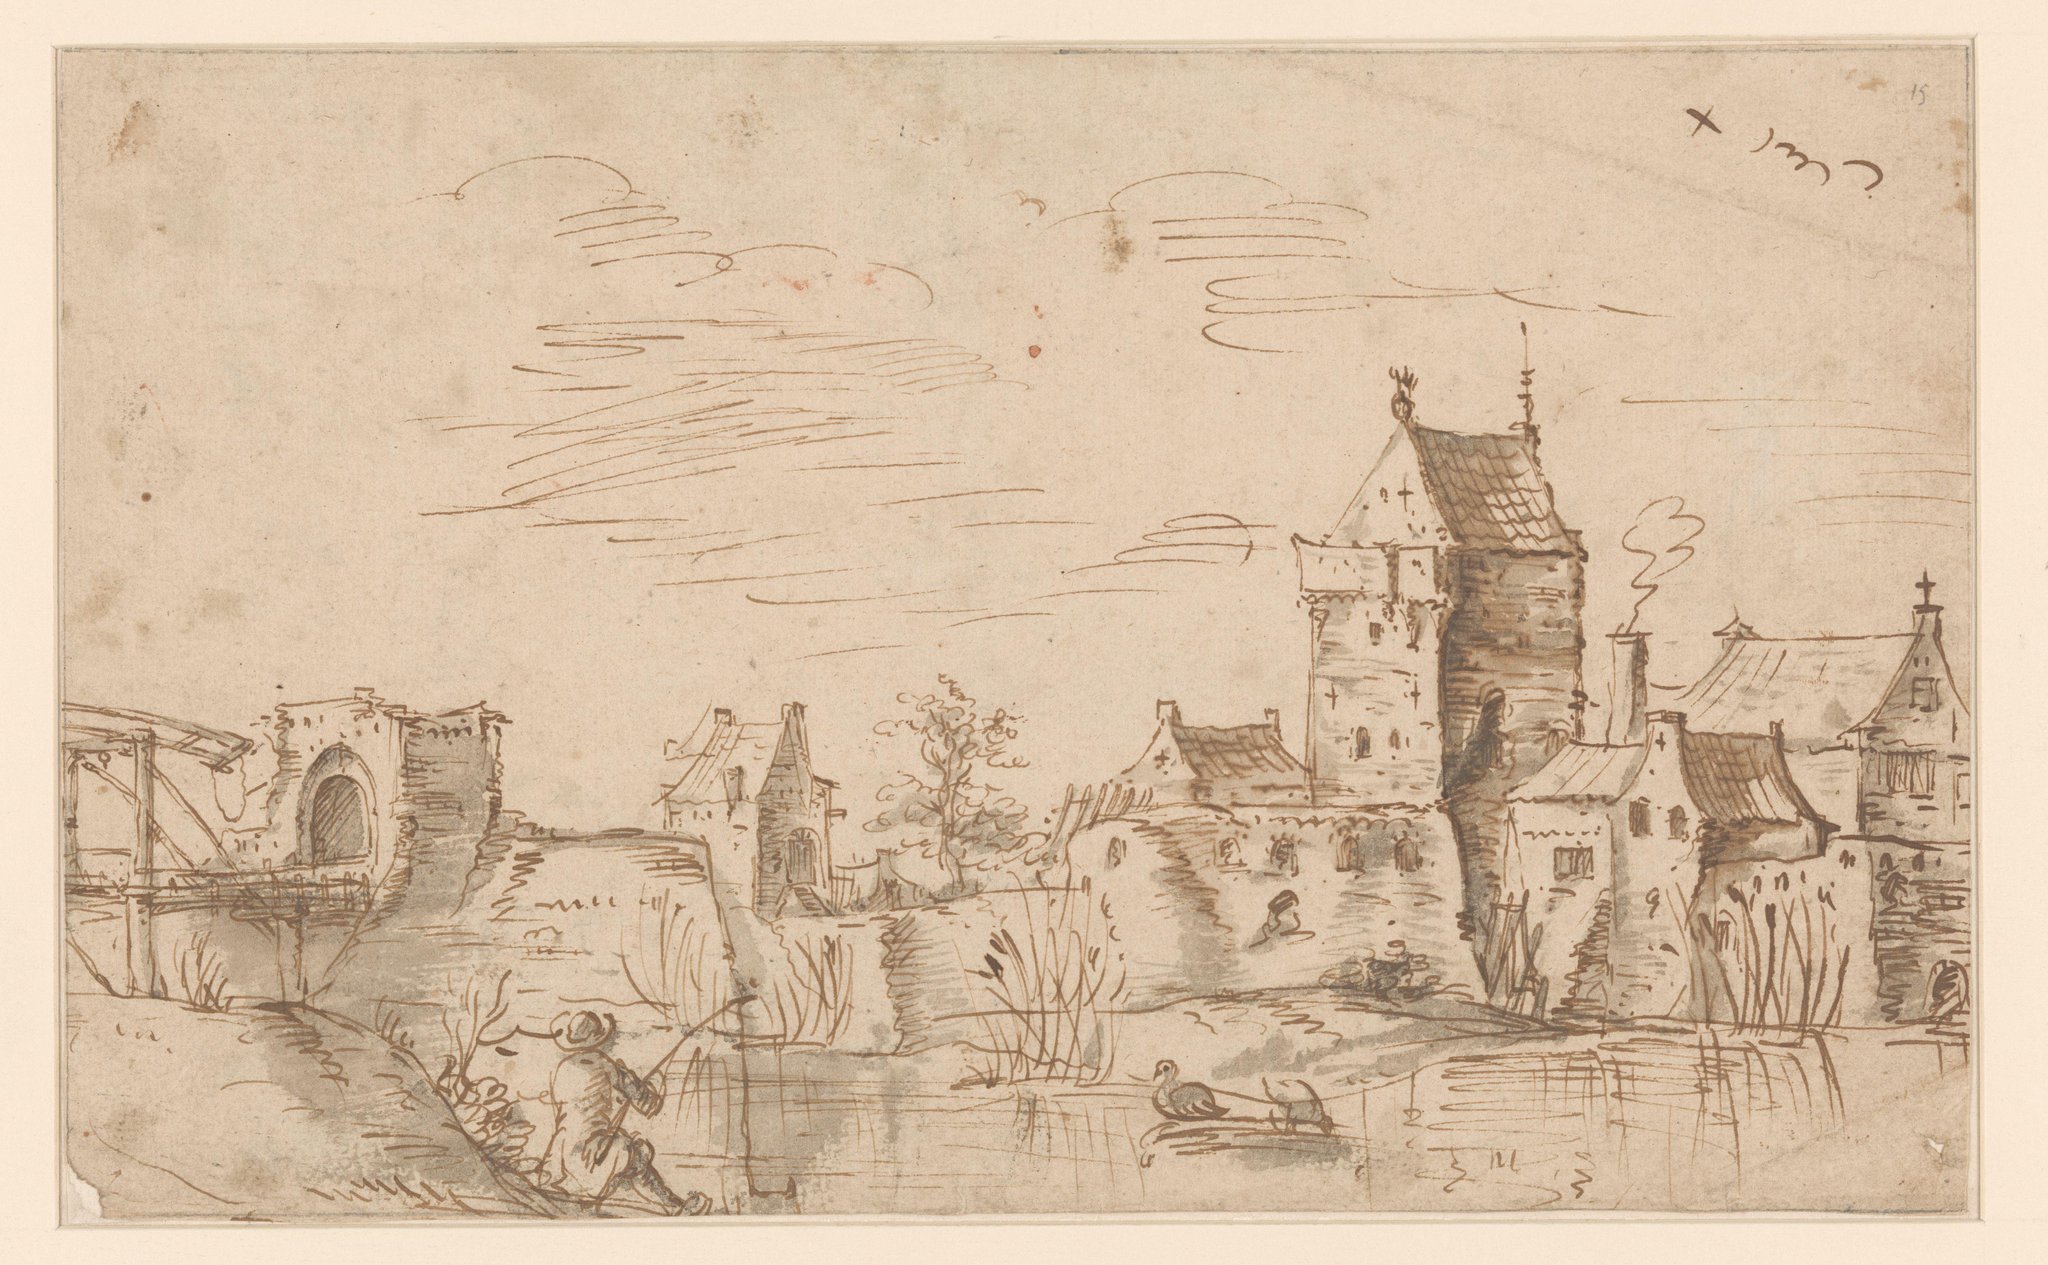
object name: drawing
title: Gezicht in Zwolle, mogelijk bij de Kamperpoort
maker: gerrit grasdorp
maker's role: draughtsman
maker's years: 1659-1716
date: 1669-1716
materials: ink, paper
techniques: brush, pen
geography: zwolle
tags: bridge in city across river, canal, etc., city-gate, angling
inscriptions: inscription: ‘Uit 't zelfde boek als G Grasdorp’, collector's mark: Lugt 2228